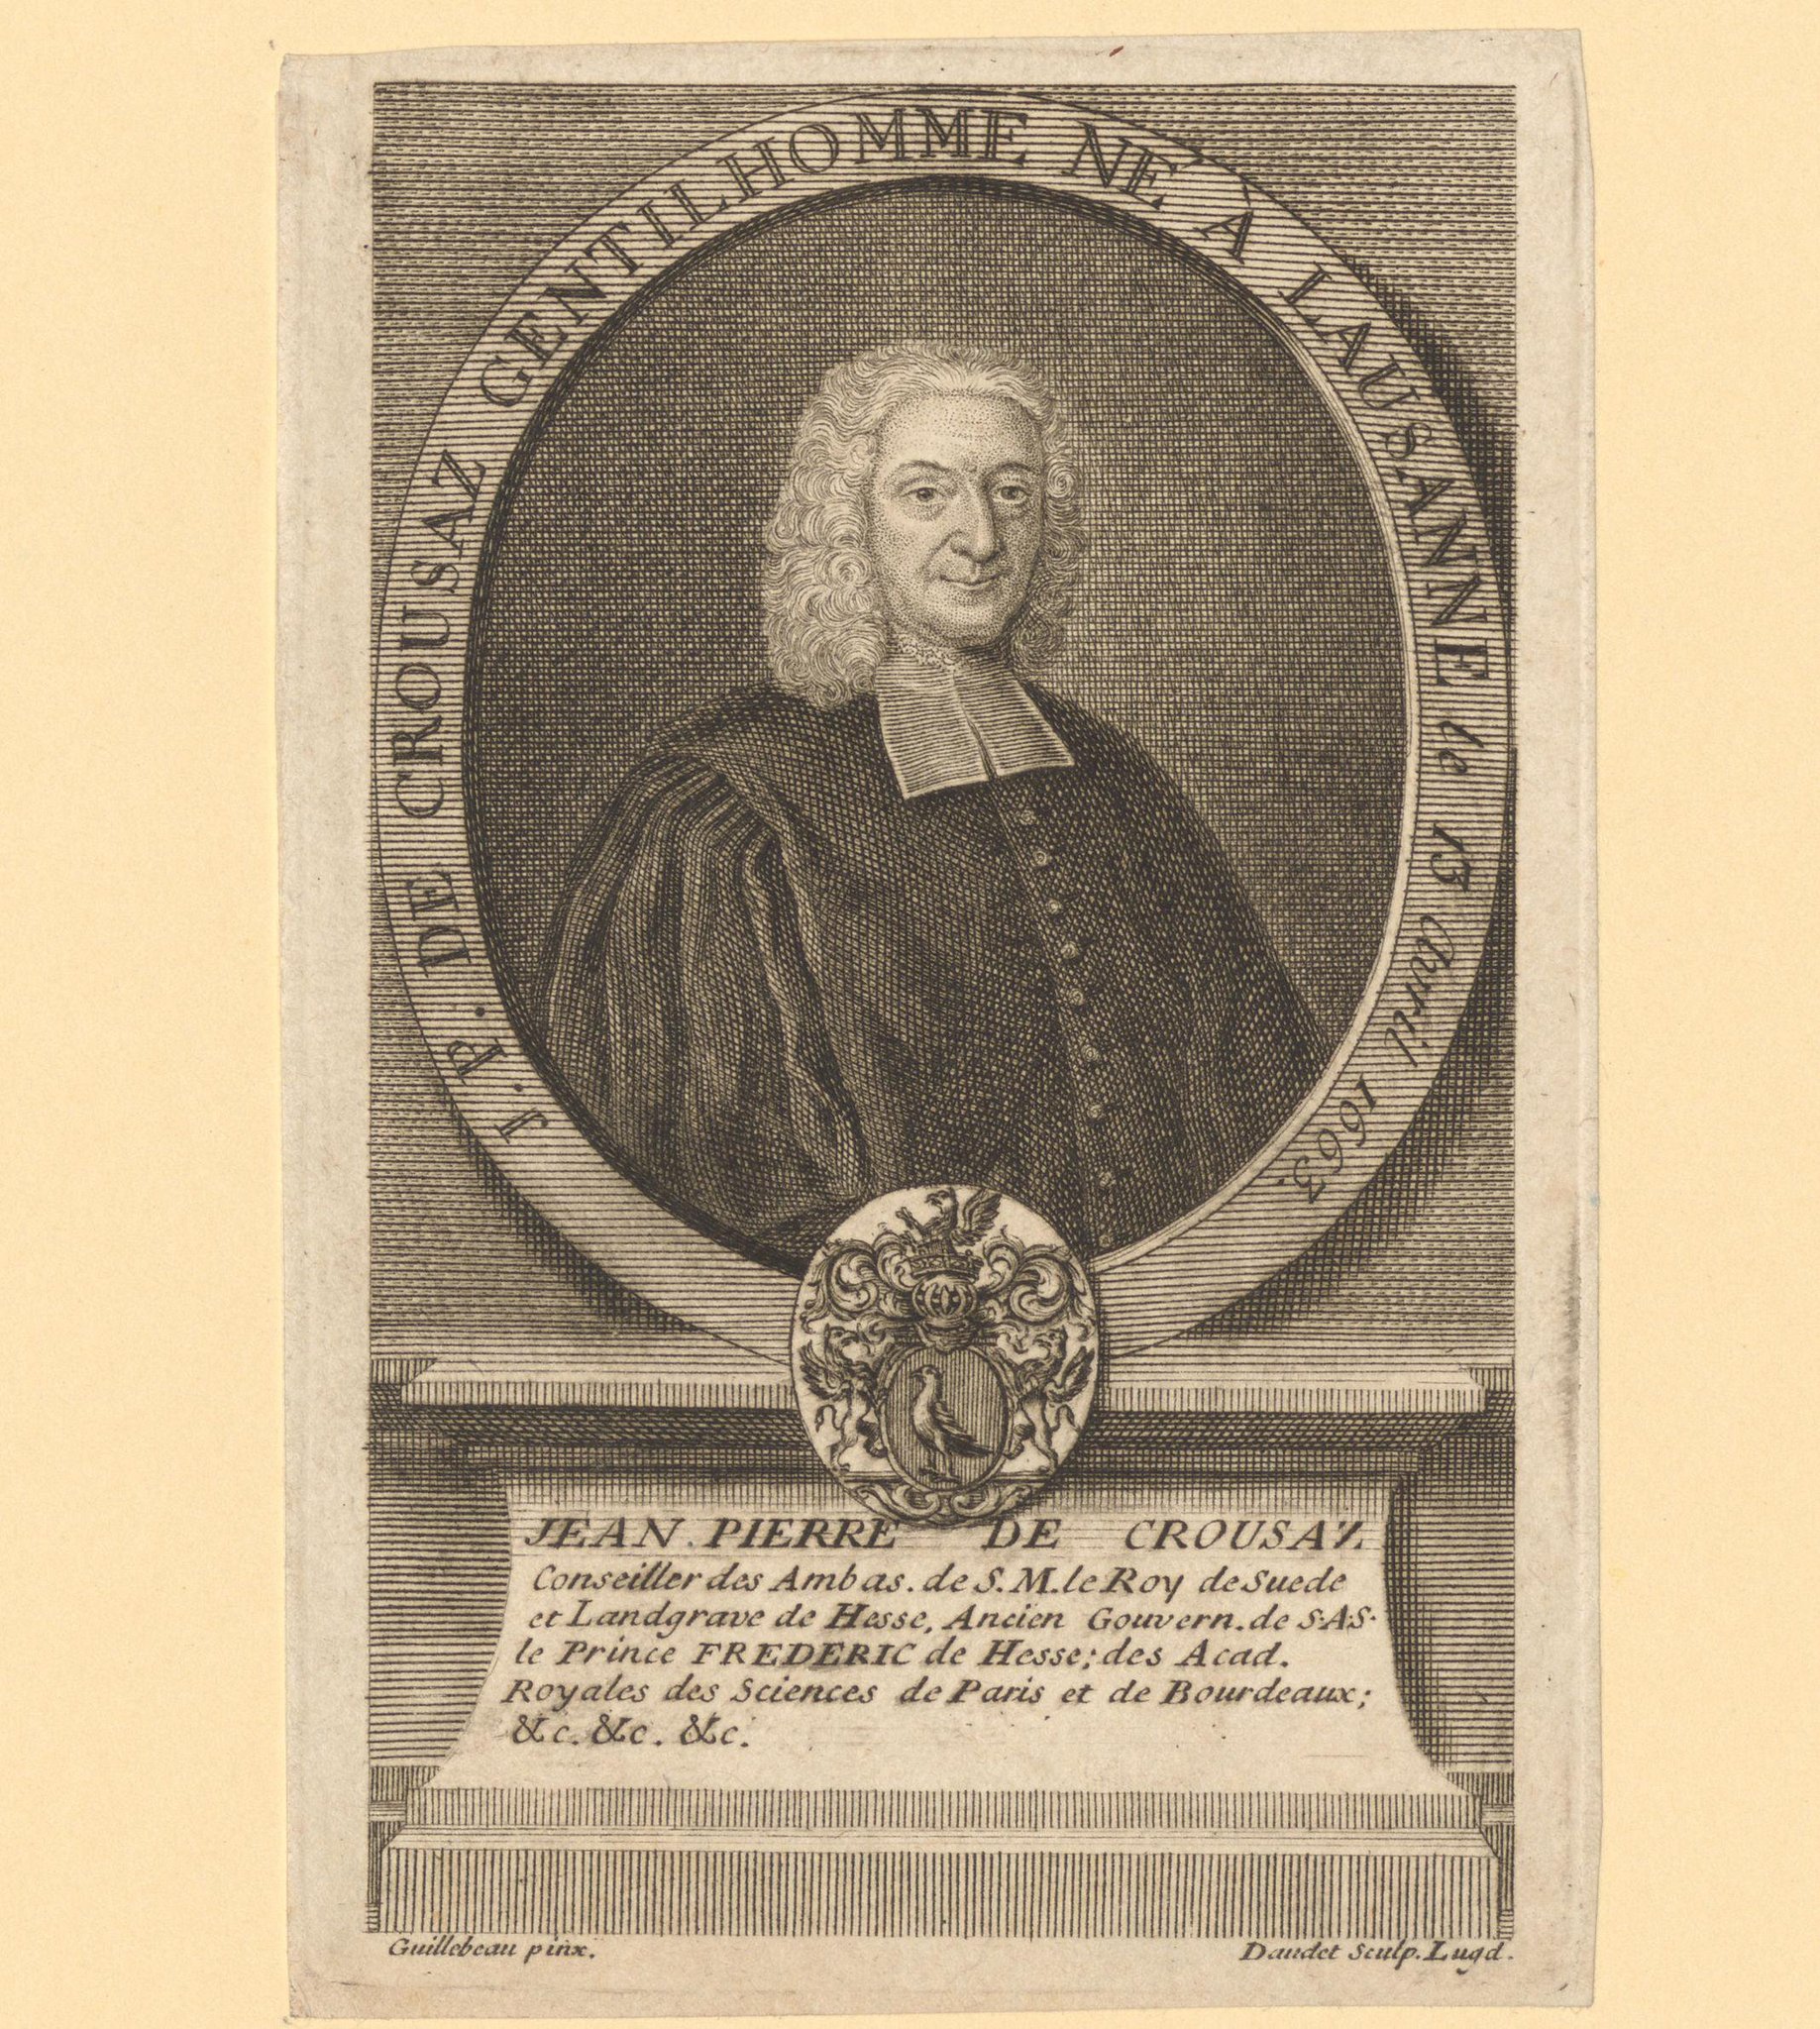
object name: print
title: Portret van Jean-Pierre de Crousaz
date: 1693-1799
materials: paper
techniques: engraving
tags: historical persons, armorial bearing, heraldry